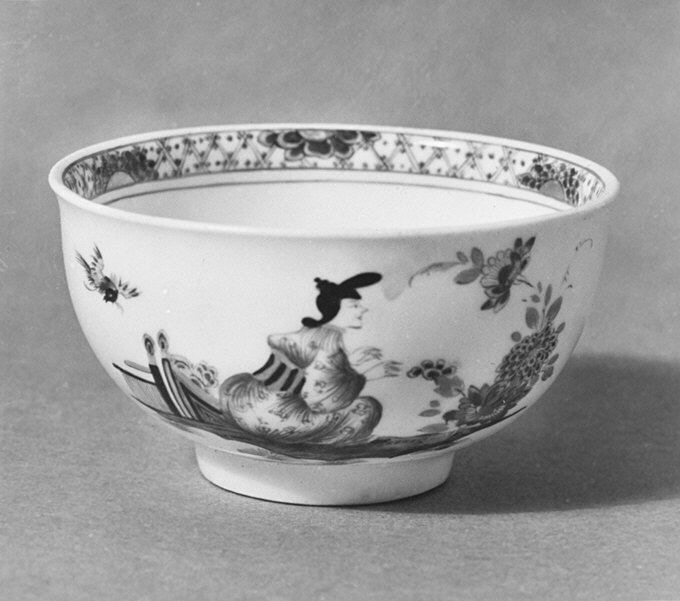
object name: cup and saucer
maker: meissen manufactory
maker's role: manufactory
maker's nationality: german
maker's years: 1710-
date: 1730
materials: hard paste porcelain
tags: human figures,chinoiserie